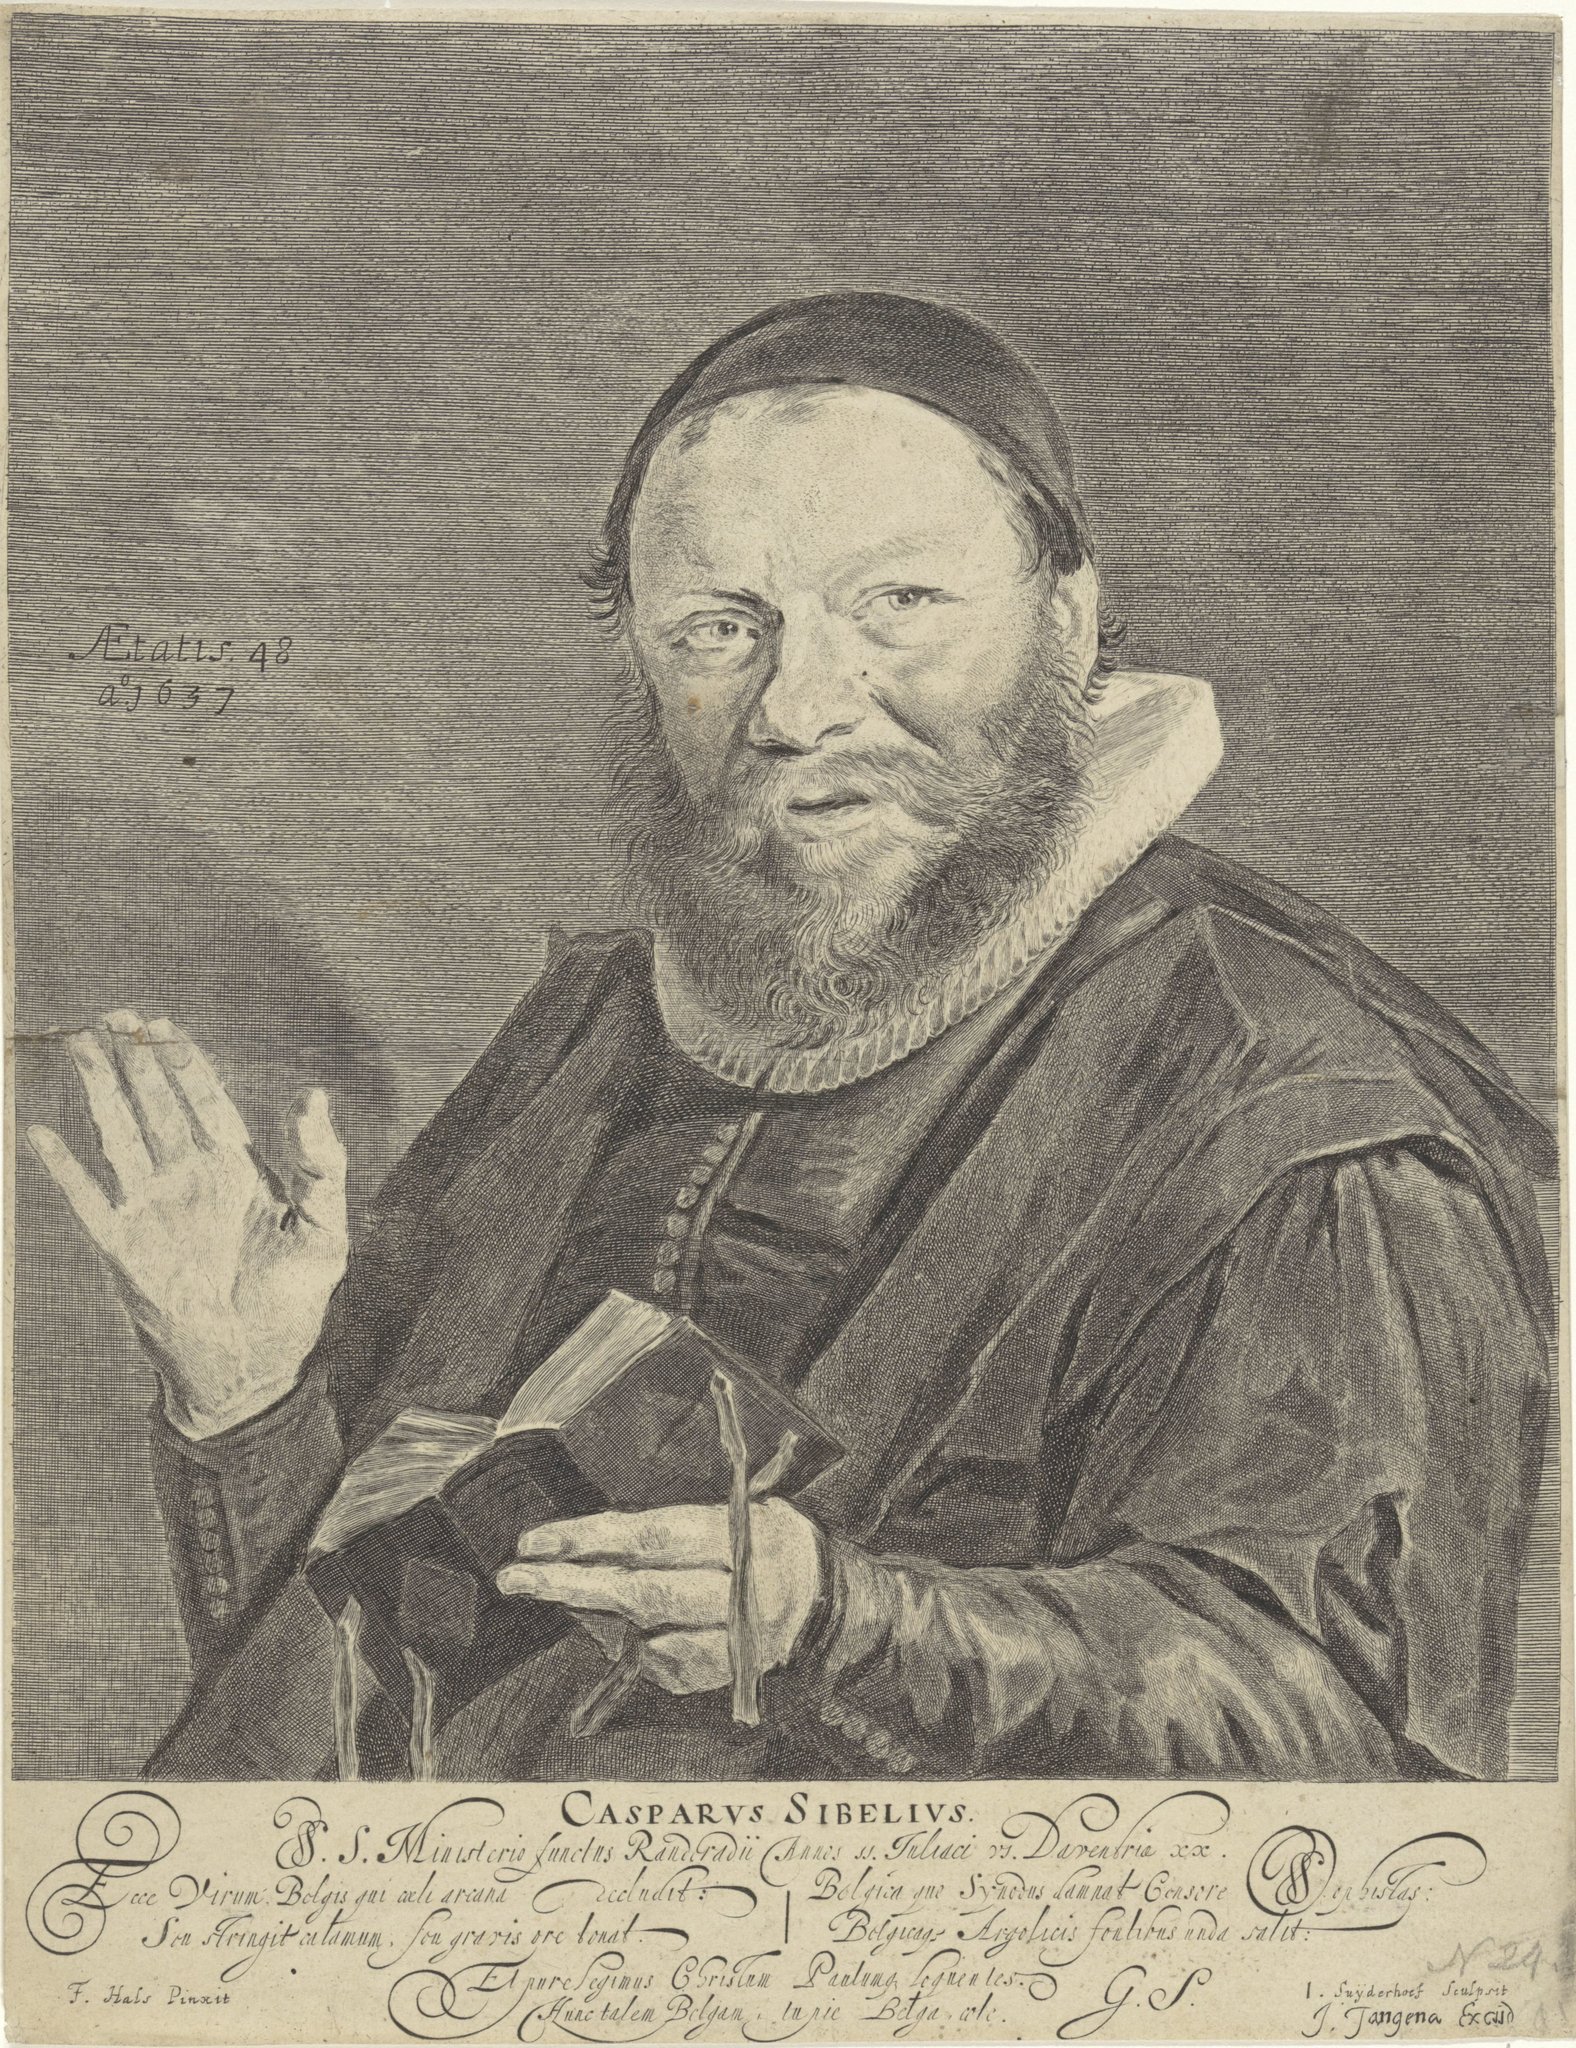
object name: print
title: Portret van Caspar Sibelius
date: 1637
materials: paper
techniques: engraving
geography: leiden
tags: deventer, functionaries and dignitaries ~ protestant churches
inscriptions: collector's mark: Lugt 2228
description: Portret van gereformeerd predikant Caspar Sibelius, met een bijbel in de hand, op 48-jarige leeftijd. Onderaan in de marge een zevenregelige tekst in het Latijn.